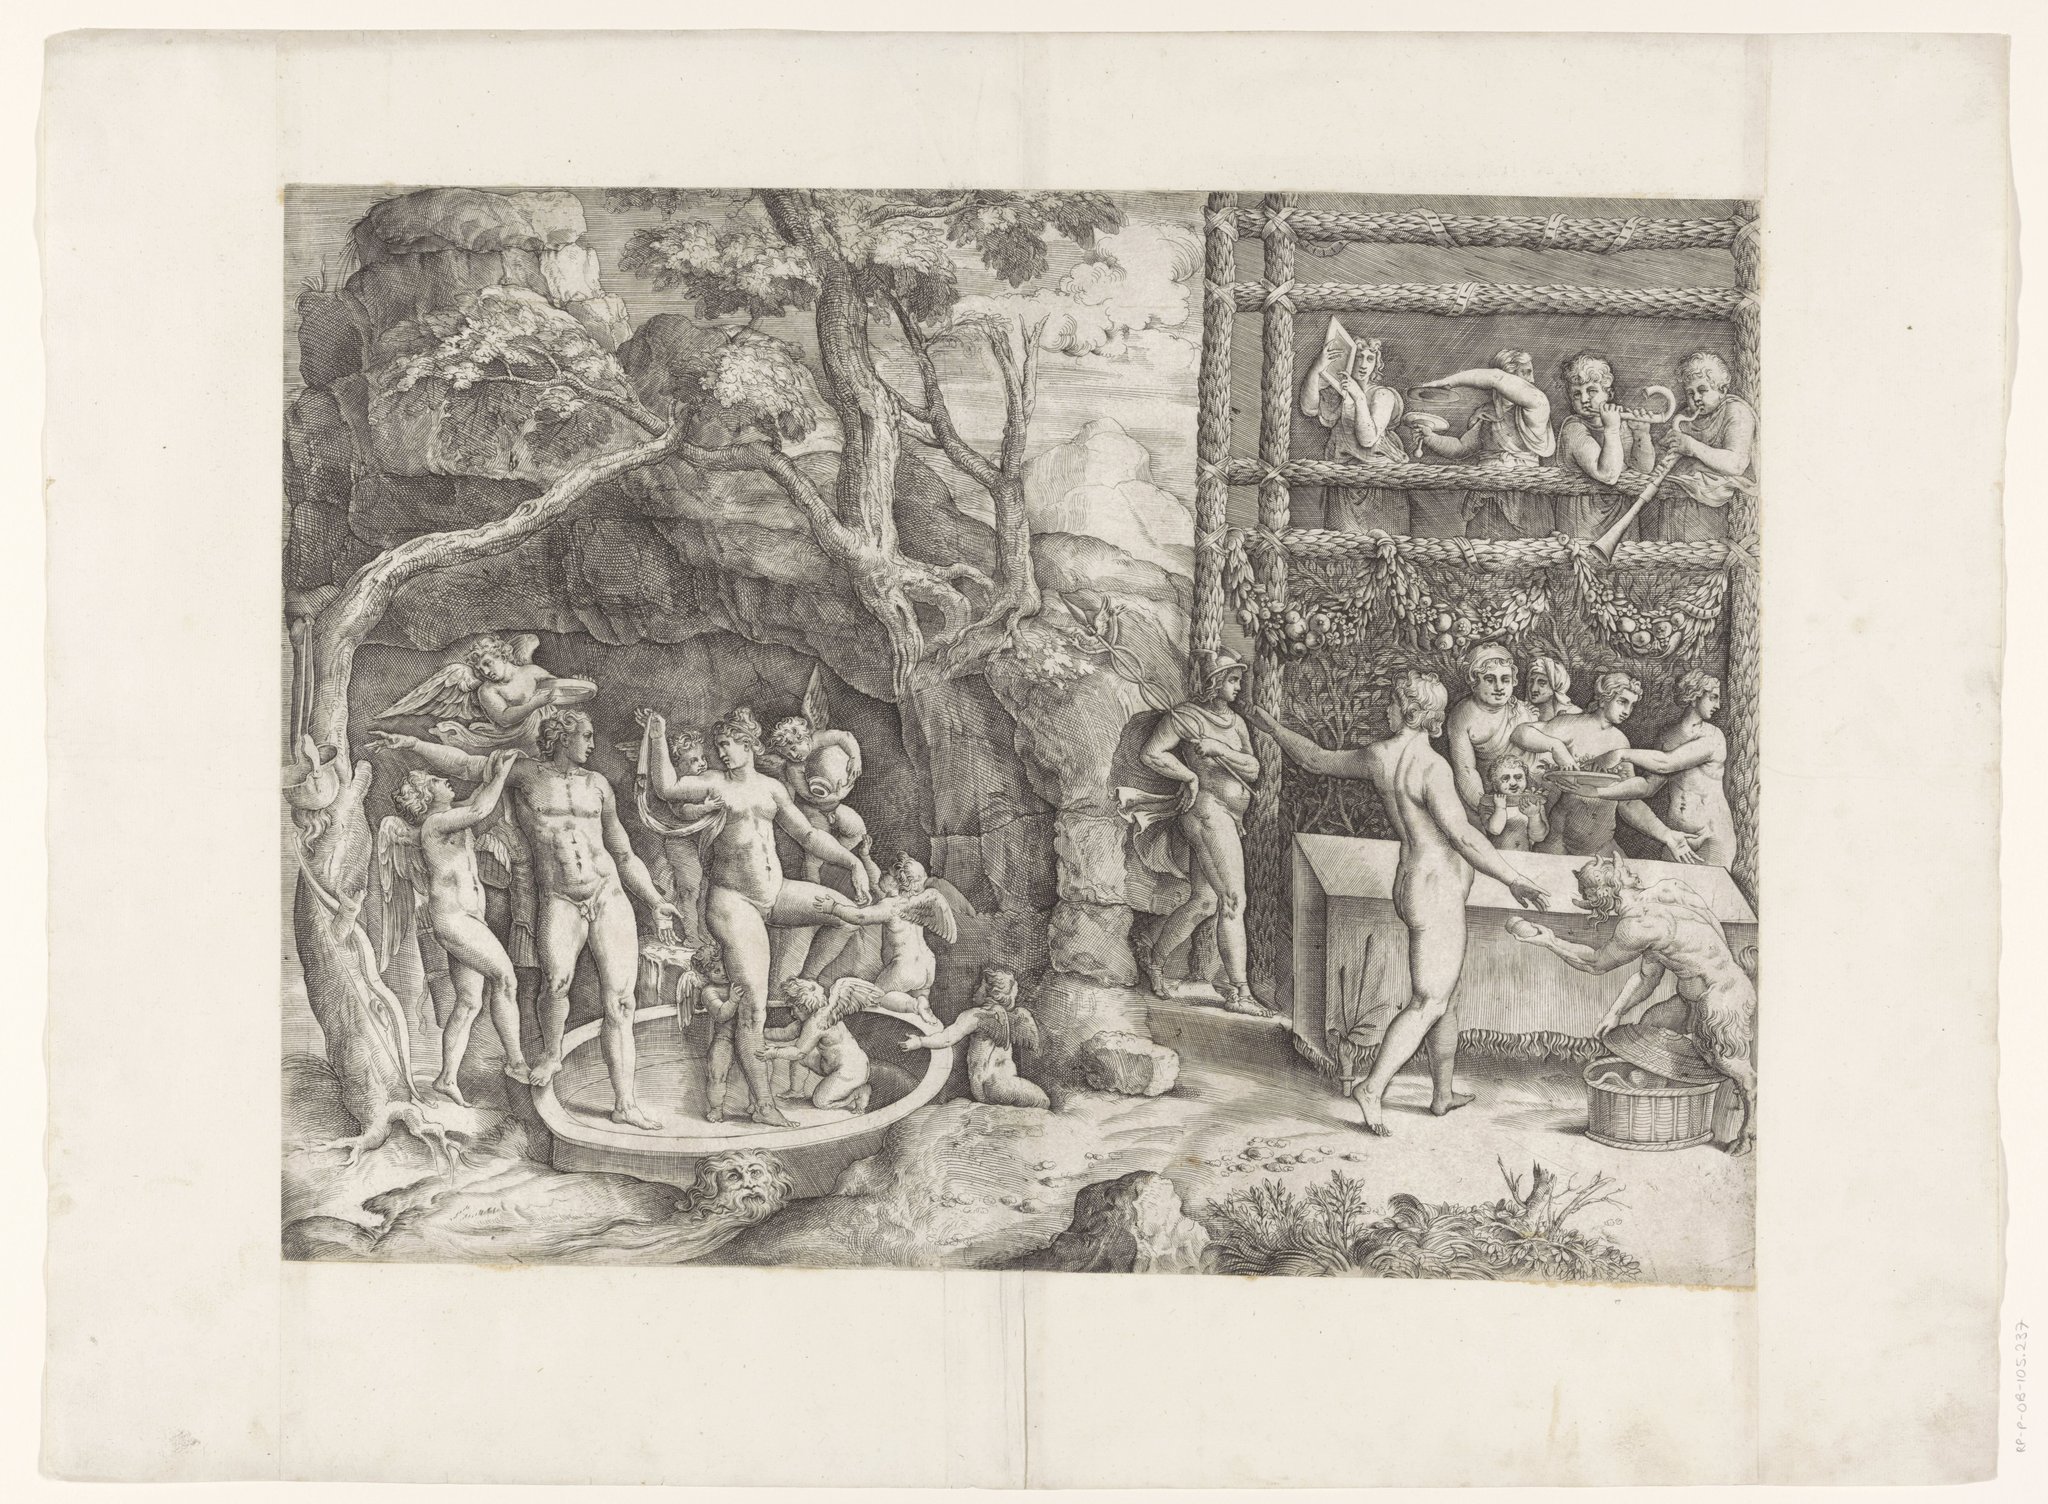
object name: print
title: Huwelijksfeest van Amor en Psyche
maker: battista franco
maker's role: draughtsman, painter, print maker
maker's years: 1510-1561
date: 1520-1561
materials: paper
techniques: engraving, etching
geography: mantua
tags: marriage of cupid and psyche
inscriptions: collector's mark: Lugt 2760, watermark, collector's mark: Lugt 2228, watermark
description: Folio 35 uit het prentalbum van Johann Georg I. Zobel von Giebelstadt (Röttingen 1543-07-20 - Bamberg 1580-09-07), de latere bisschop van Bamberg. Het album is vermoedelijk samengesteld tussen 1568 en 1570 in Venetië. Het album werd in 1999 uit elkaar genomen door een antiquair. De in totaal 124 folio's met prenten uit het "Zobel Album" werden aangekocht door verschillende musea en privéverzamelingen. De grootste groep (68 folio's) bevindt zich in de collectie van het Rijksmuseum. De getekende voorstudie door Giovanni Battista Franco bevindt zich het Britisch Museum te Londen (inv. nr.: 1946,0713.1282). Franco kopieerde deze voorstelling naar een fresco door Giulio Romano op de zuid-west wand van de Camera di Amore e Psyche, in het Palazzo del Te in Mantua. RP-P-OB-105.238 en RP-P-OB-105.237 vormen samen één groot fries, gedrukt van twee platen op twee bladen.